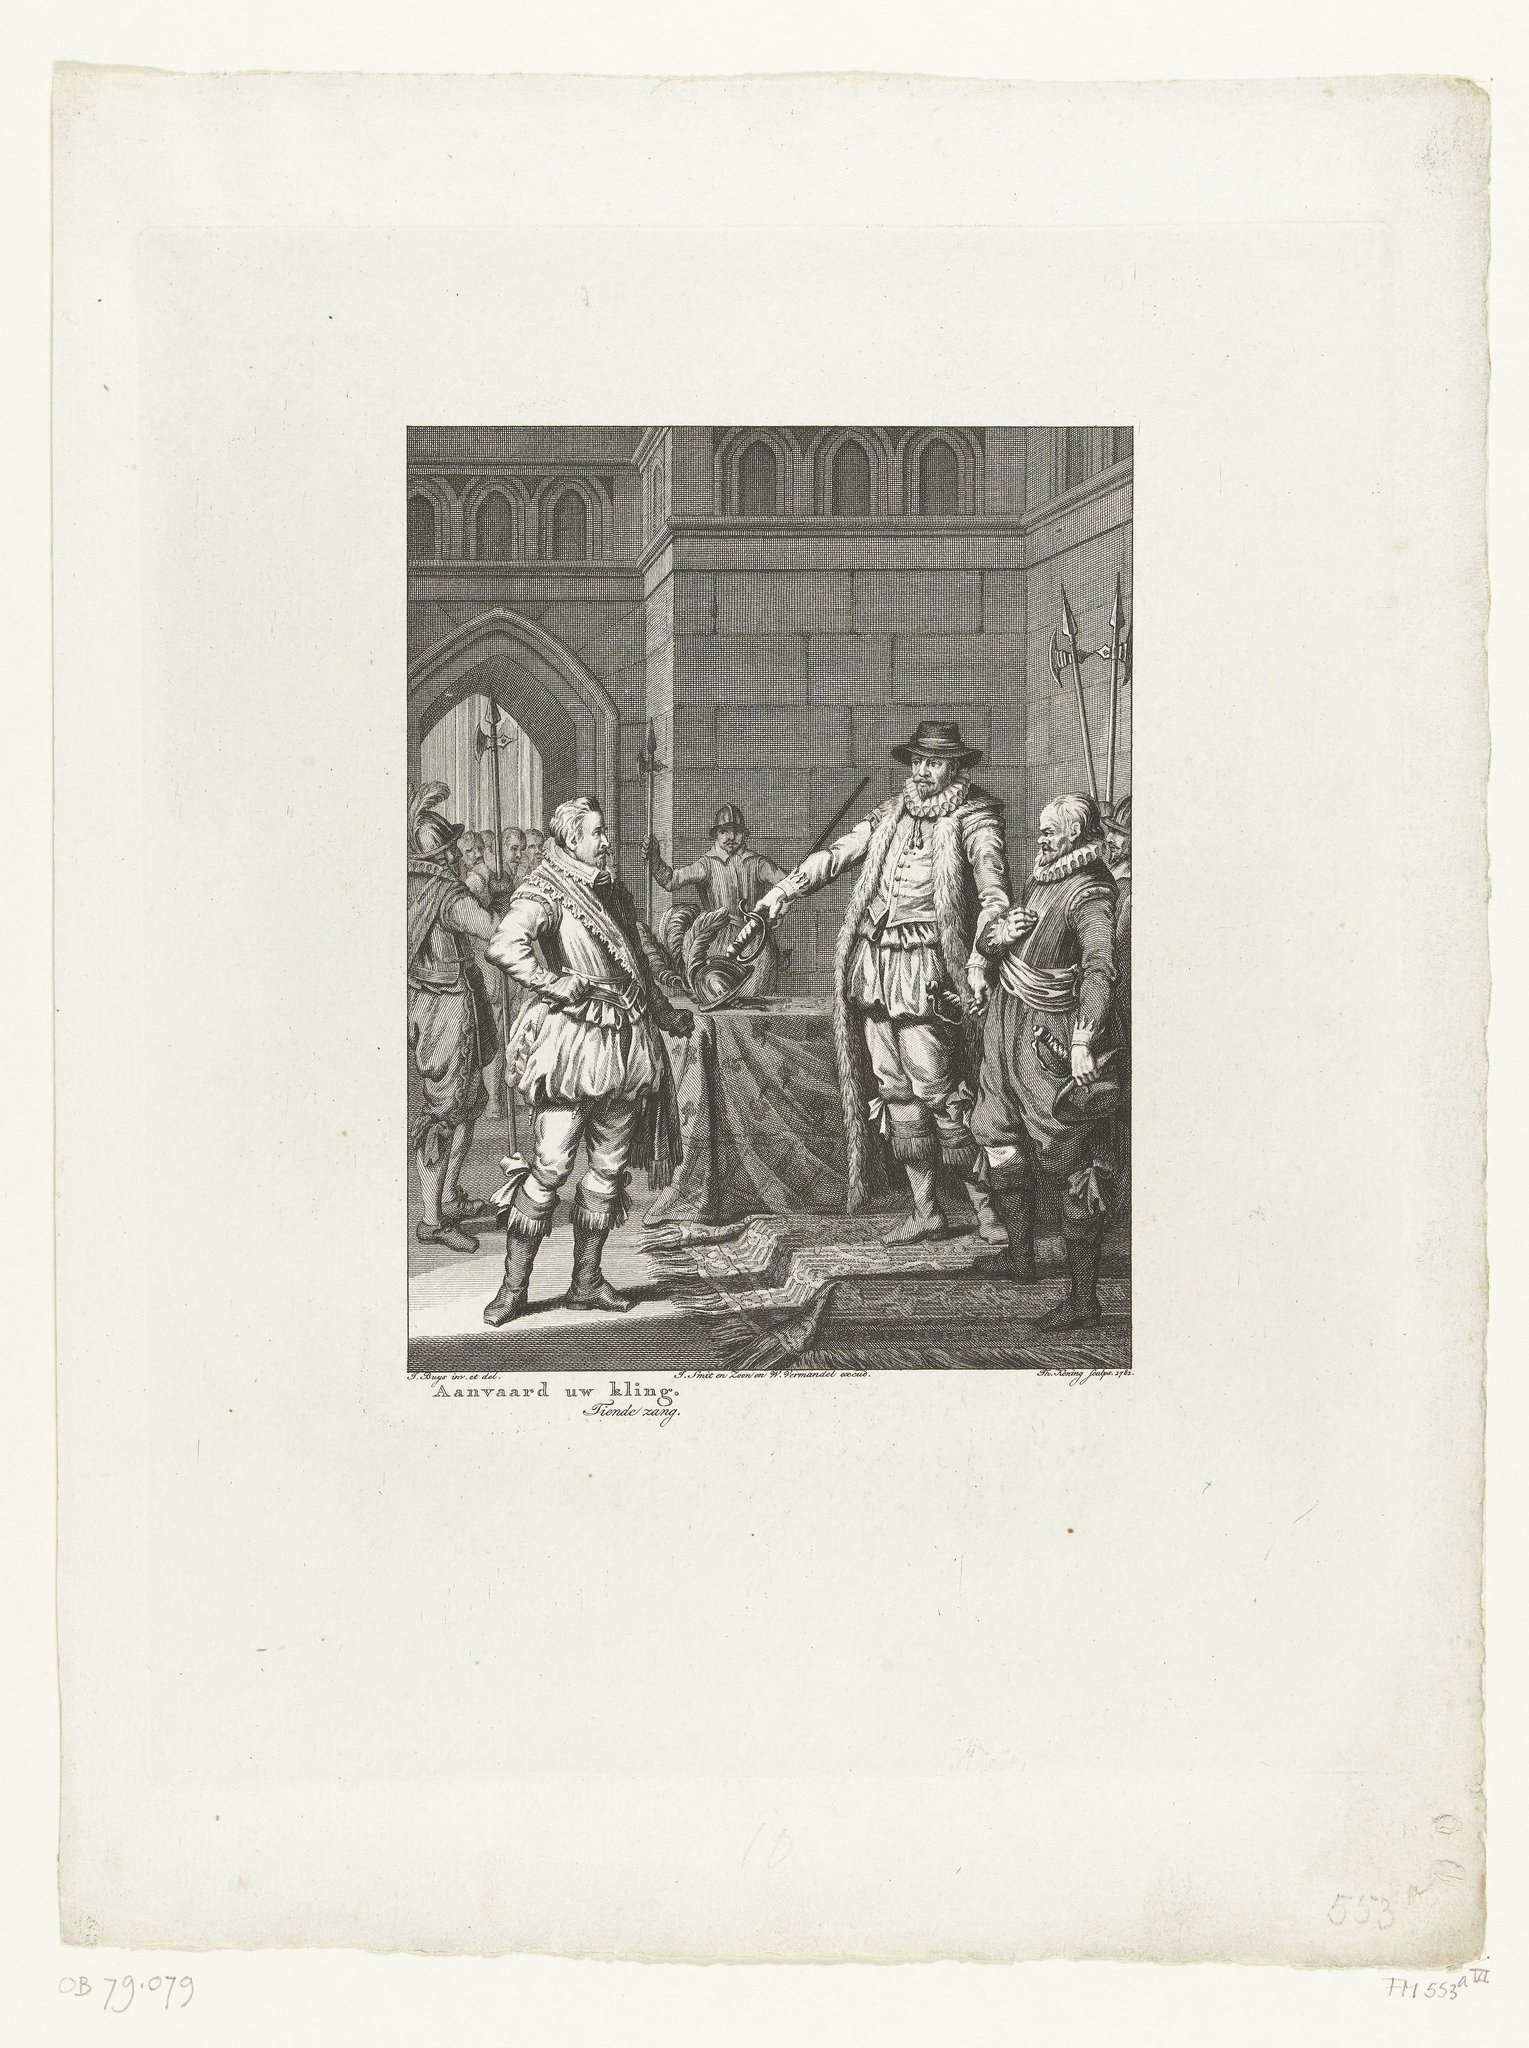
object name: print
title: Oranje geeft Bossu te Hoorn zijn zwaard terug, 1573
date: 1781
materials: paper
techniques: etching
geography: amsterdam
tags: delft, william i (prince of orange), antwerp, earl, hoorn (north holland)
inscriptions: date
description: Illustratie voor: J. Nomsz, Willem de eerste, of de grondlegging der Nederlandsche vryheid. : In vier en twintig zangen, Erven van David Klippink, Amsterdam 1779. Staat met de letter.